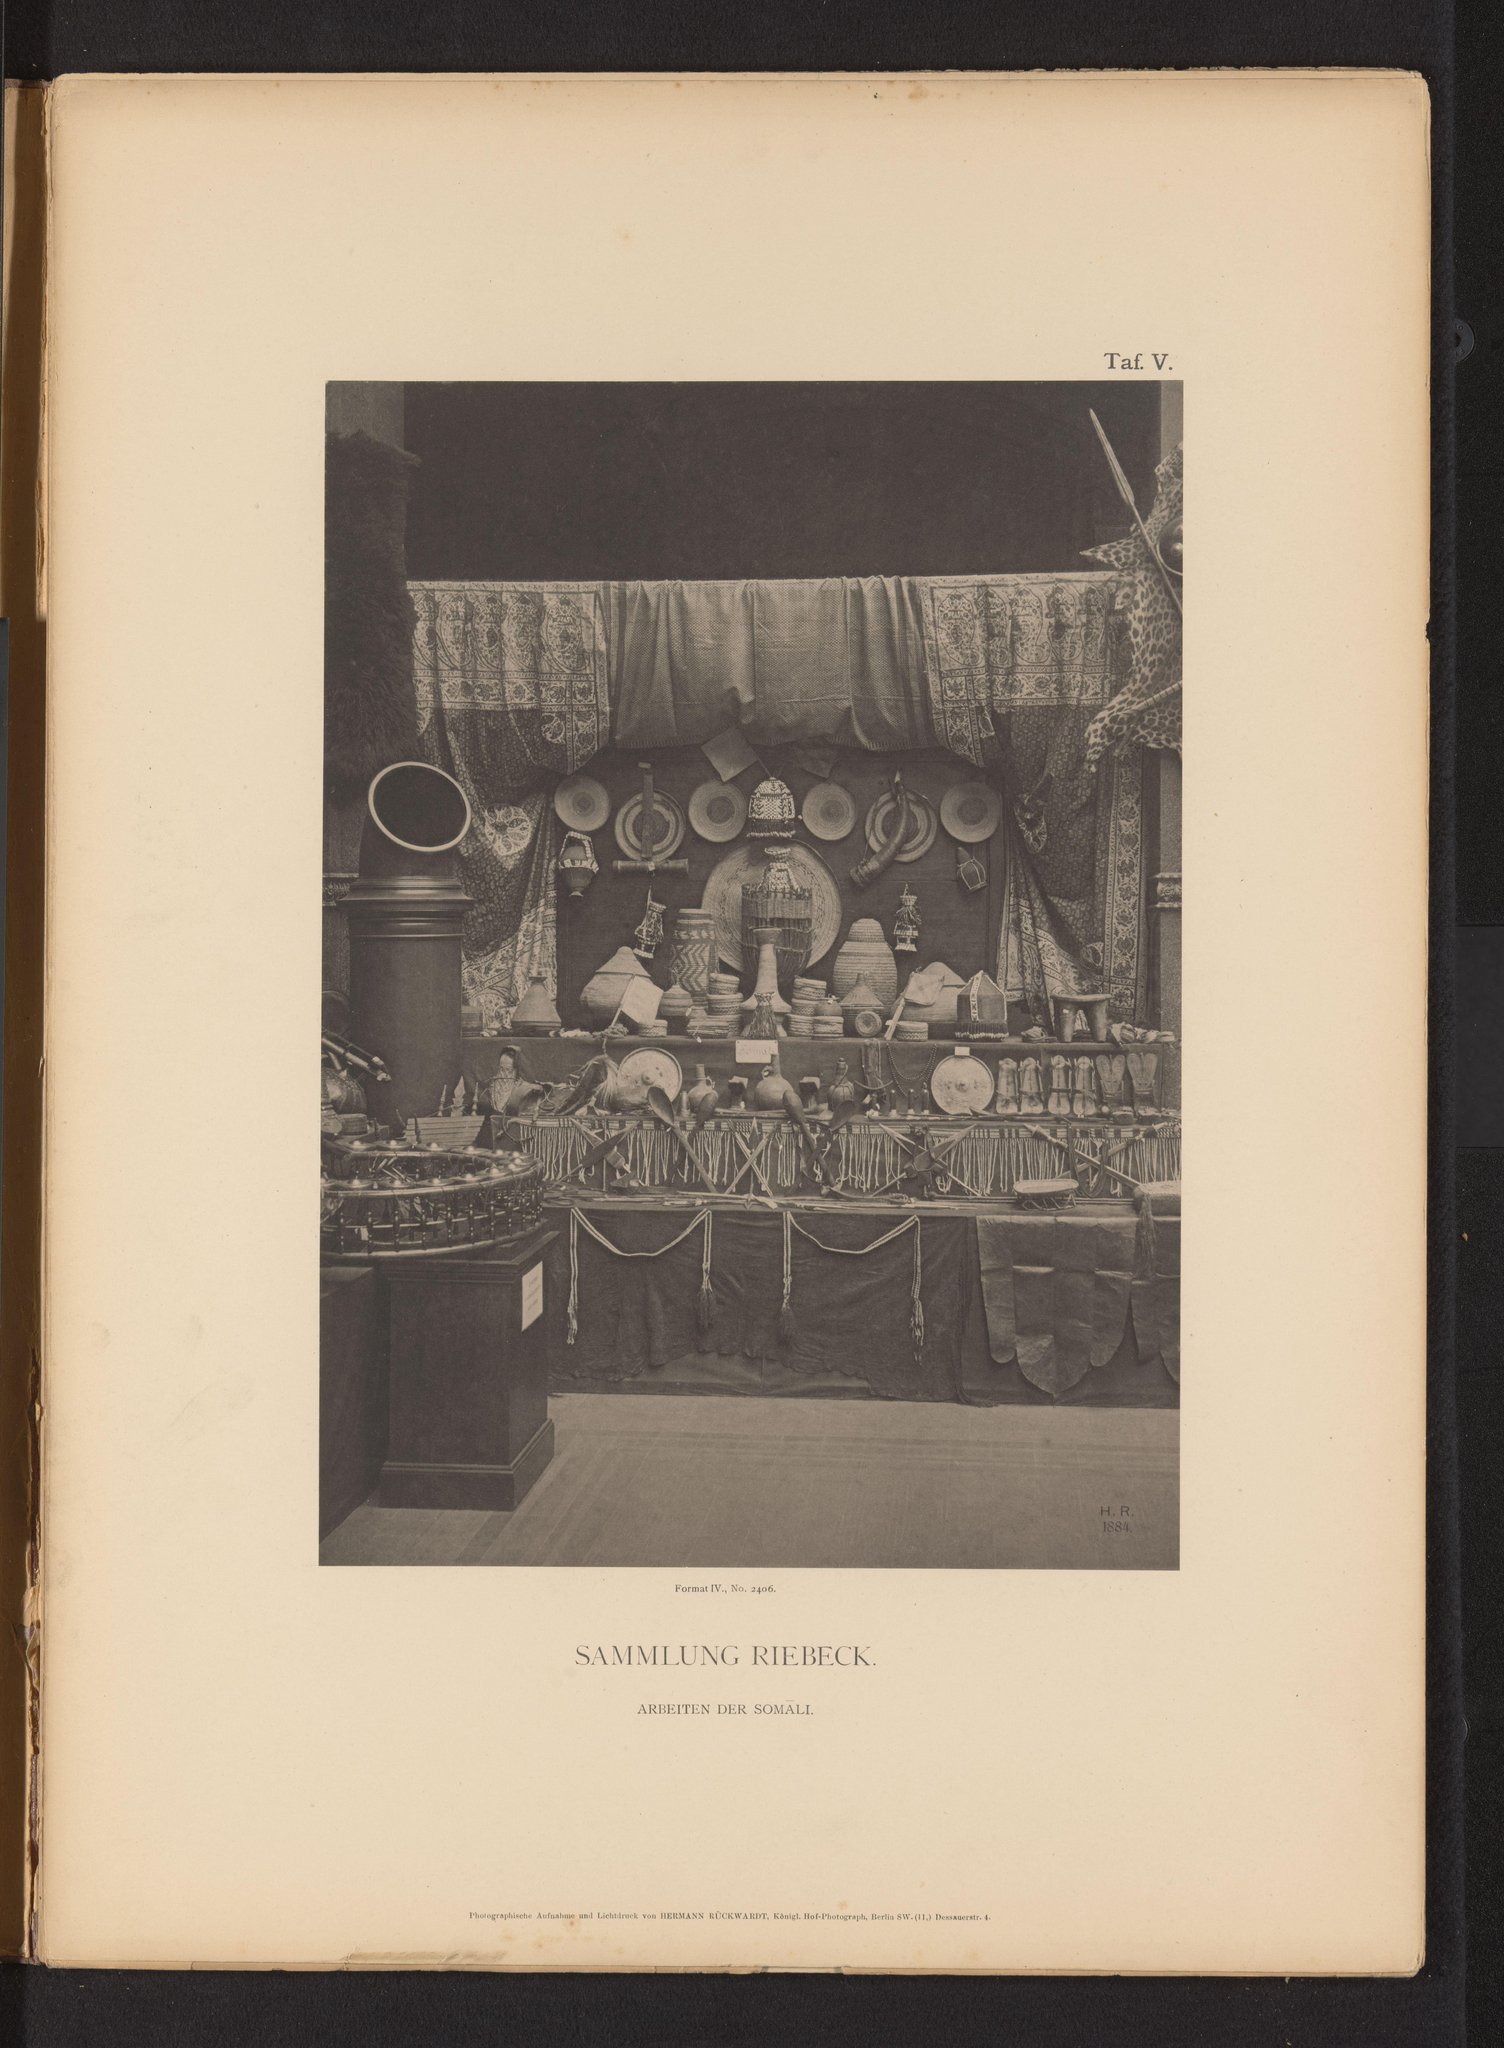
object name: photomechanical print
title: Objecten uit Somalië uit de verzameling van Emil Riebeck, op de binnenplaats van het Kunstgewerbemuseum in Berlijn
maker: hermann rückwardt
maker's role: fotograaf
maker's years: 1845-1919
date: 1884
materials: paper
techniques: photograph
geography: berlin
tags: permanent exhibition, museum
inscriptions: number: ‘Format IV., No. 2406.’, number: ‘Taf. V.’, address: ‘Photographische Aufnahme und Lichtdruck von HERMANN RÜCKWARDT, Königl. Hof-Photograph, Berlin SW.(11,) Dessauerstr. 4.’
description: Deze prent maakt deel uit van een omslag met 21 prenten en 1 tekstblad.